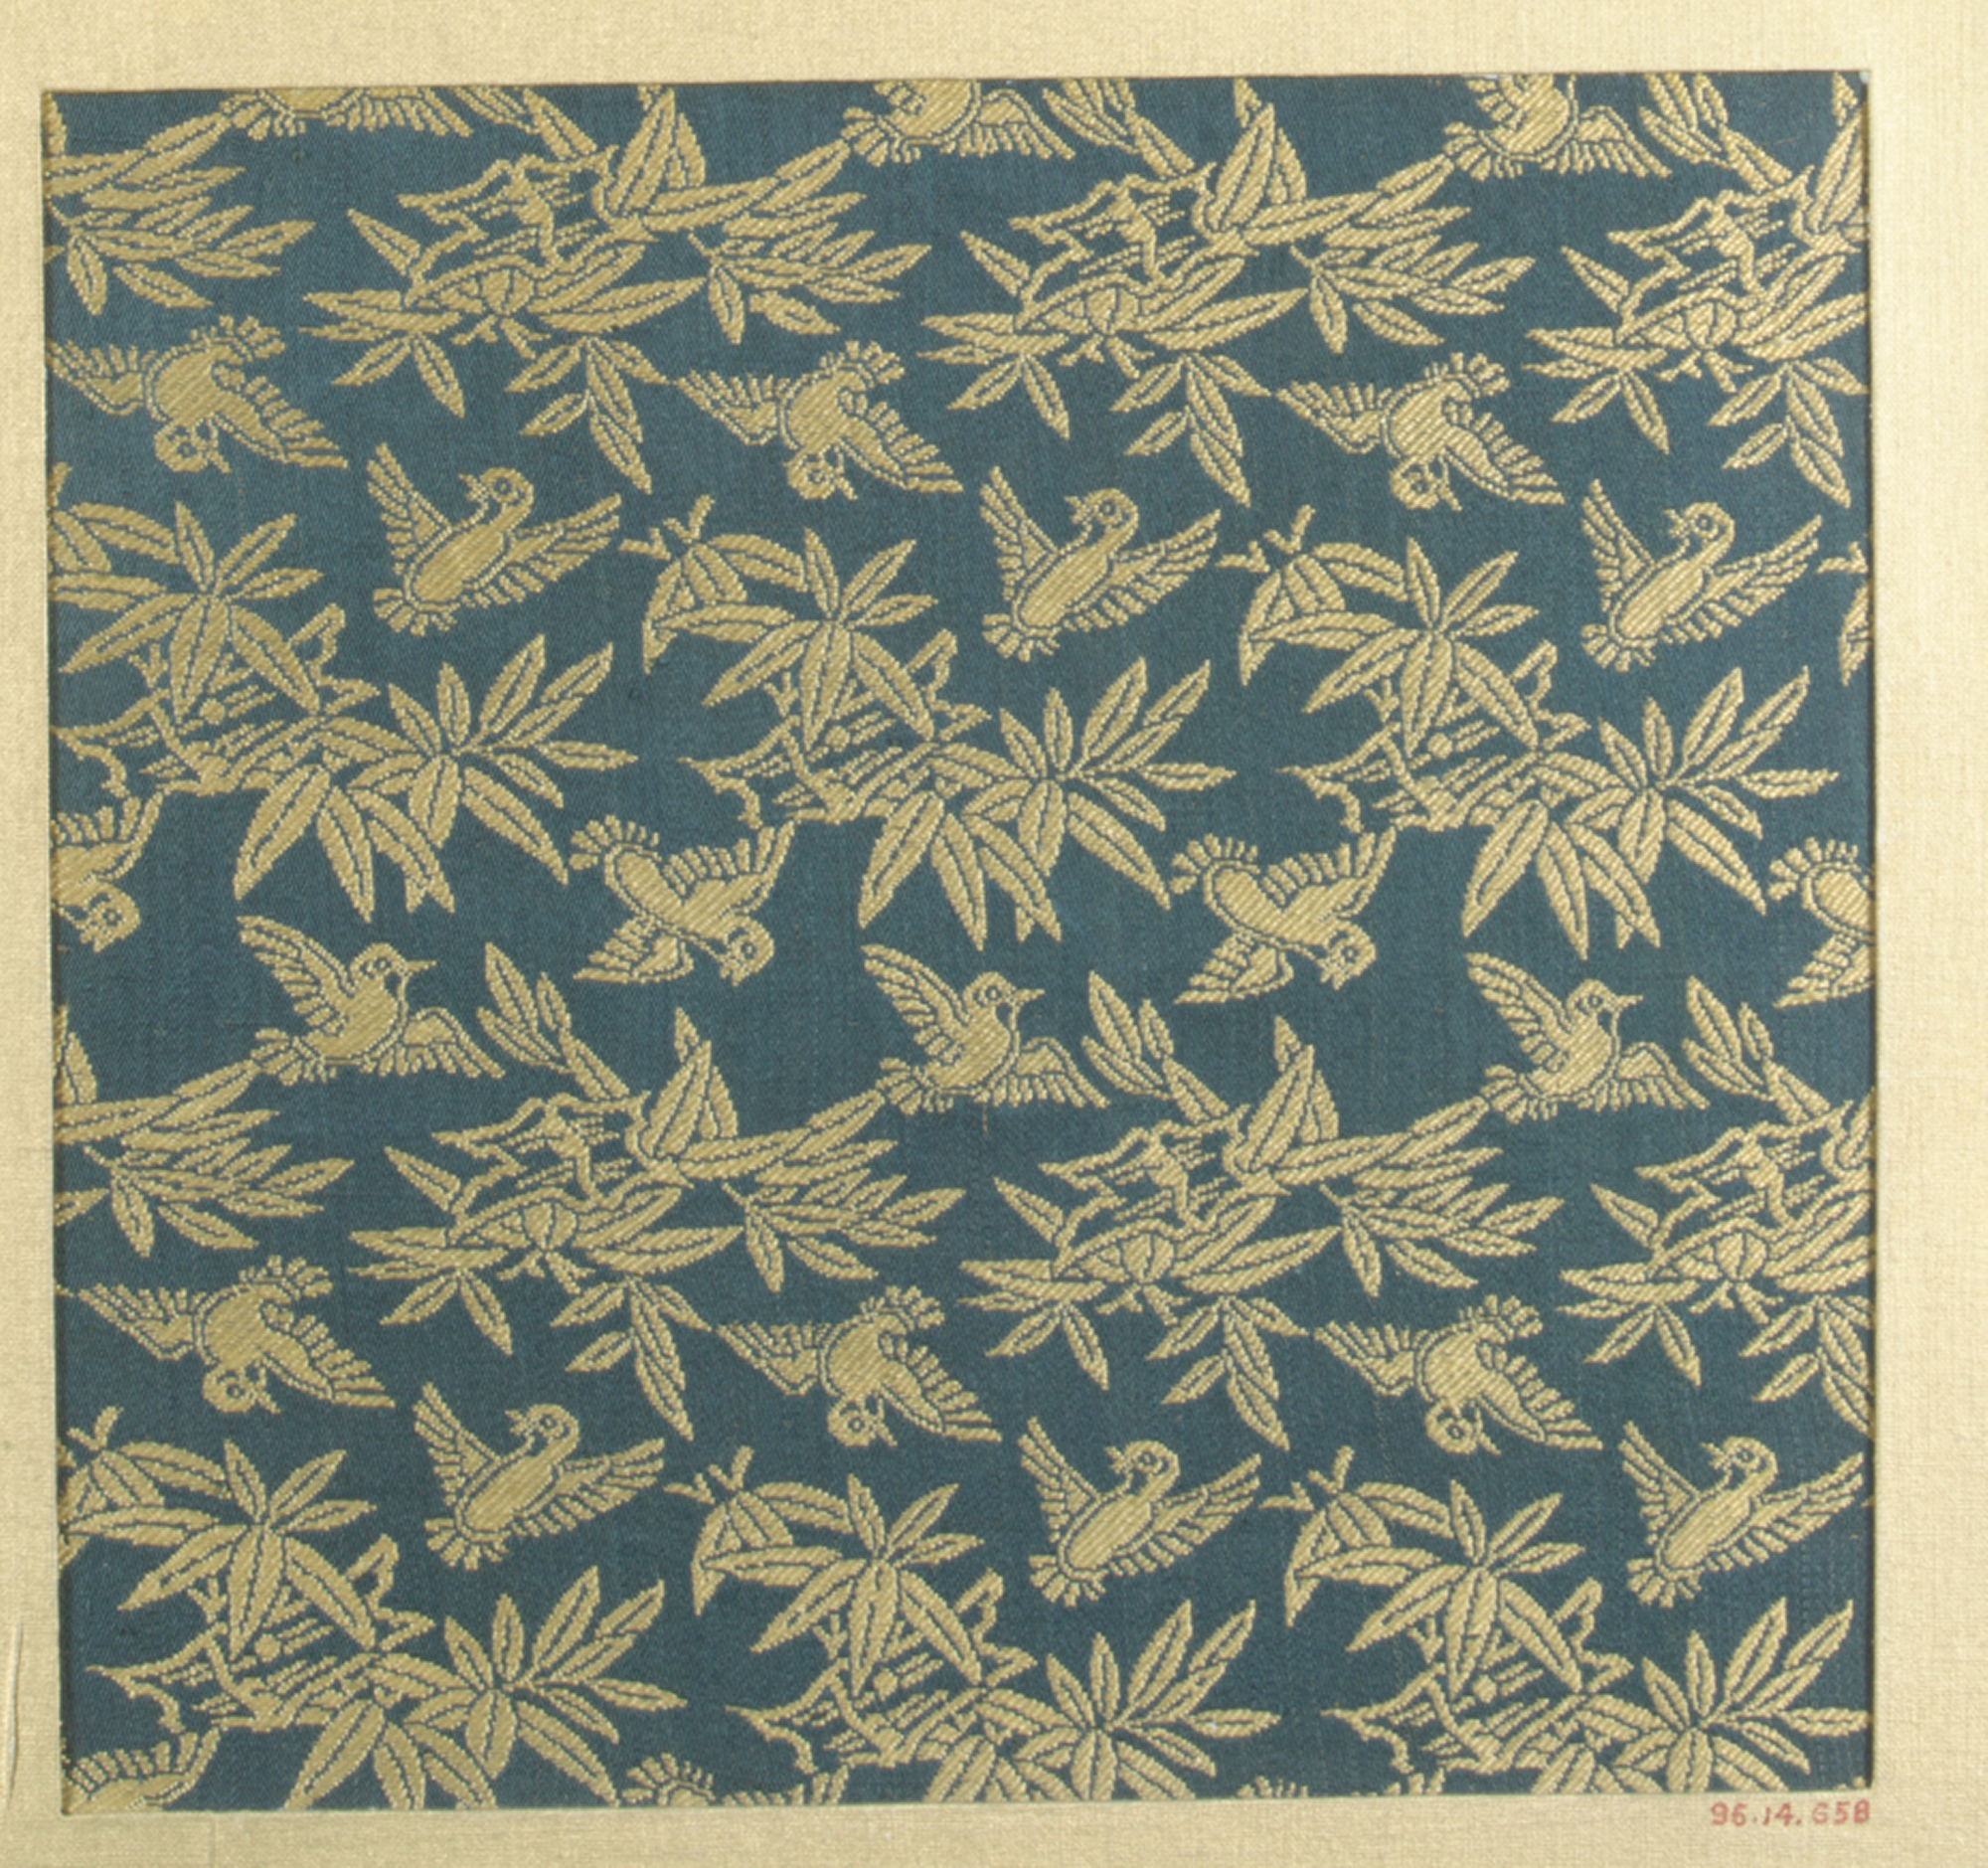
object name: piece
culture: japanese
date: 1701-1900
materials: silk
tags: leaves